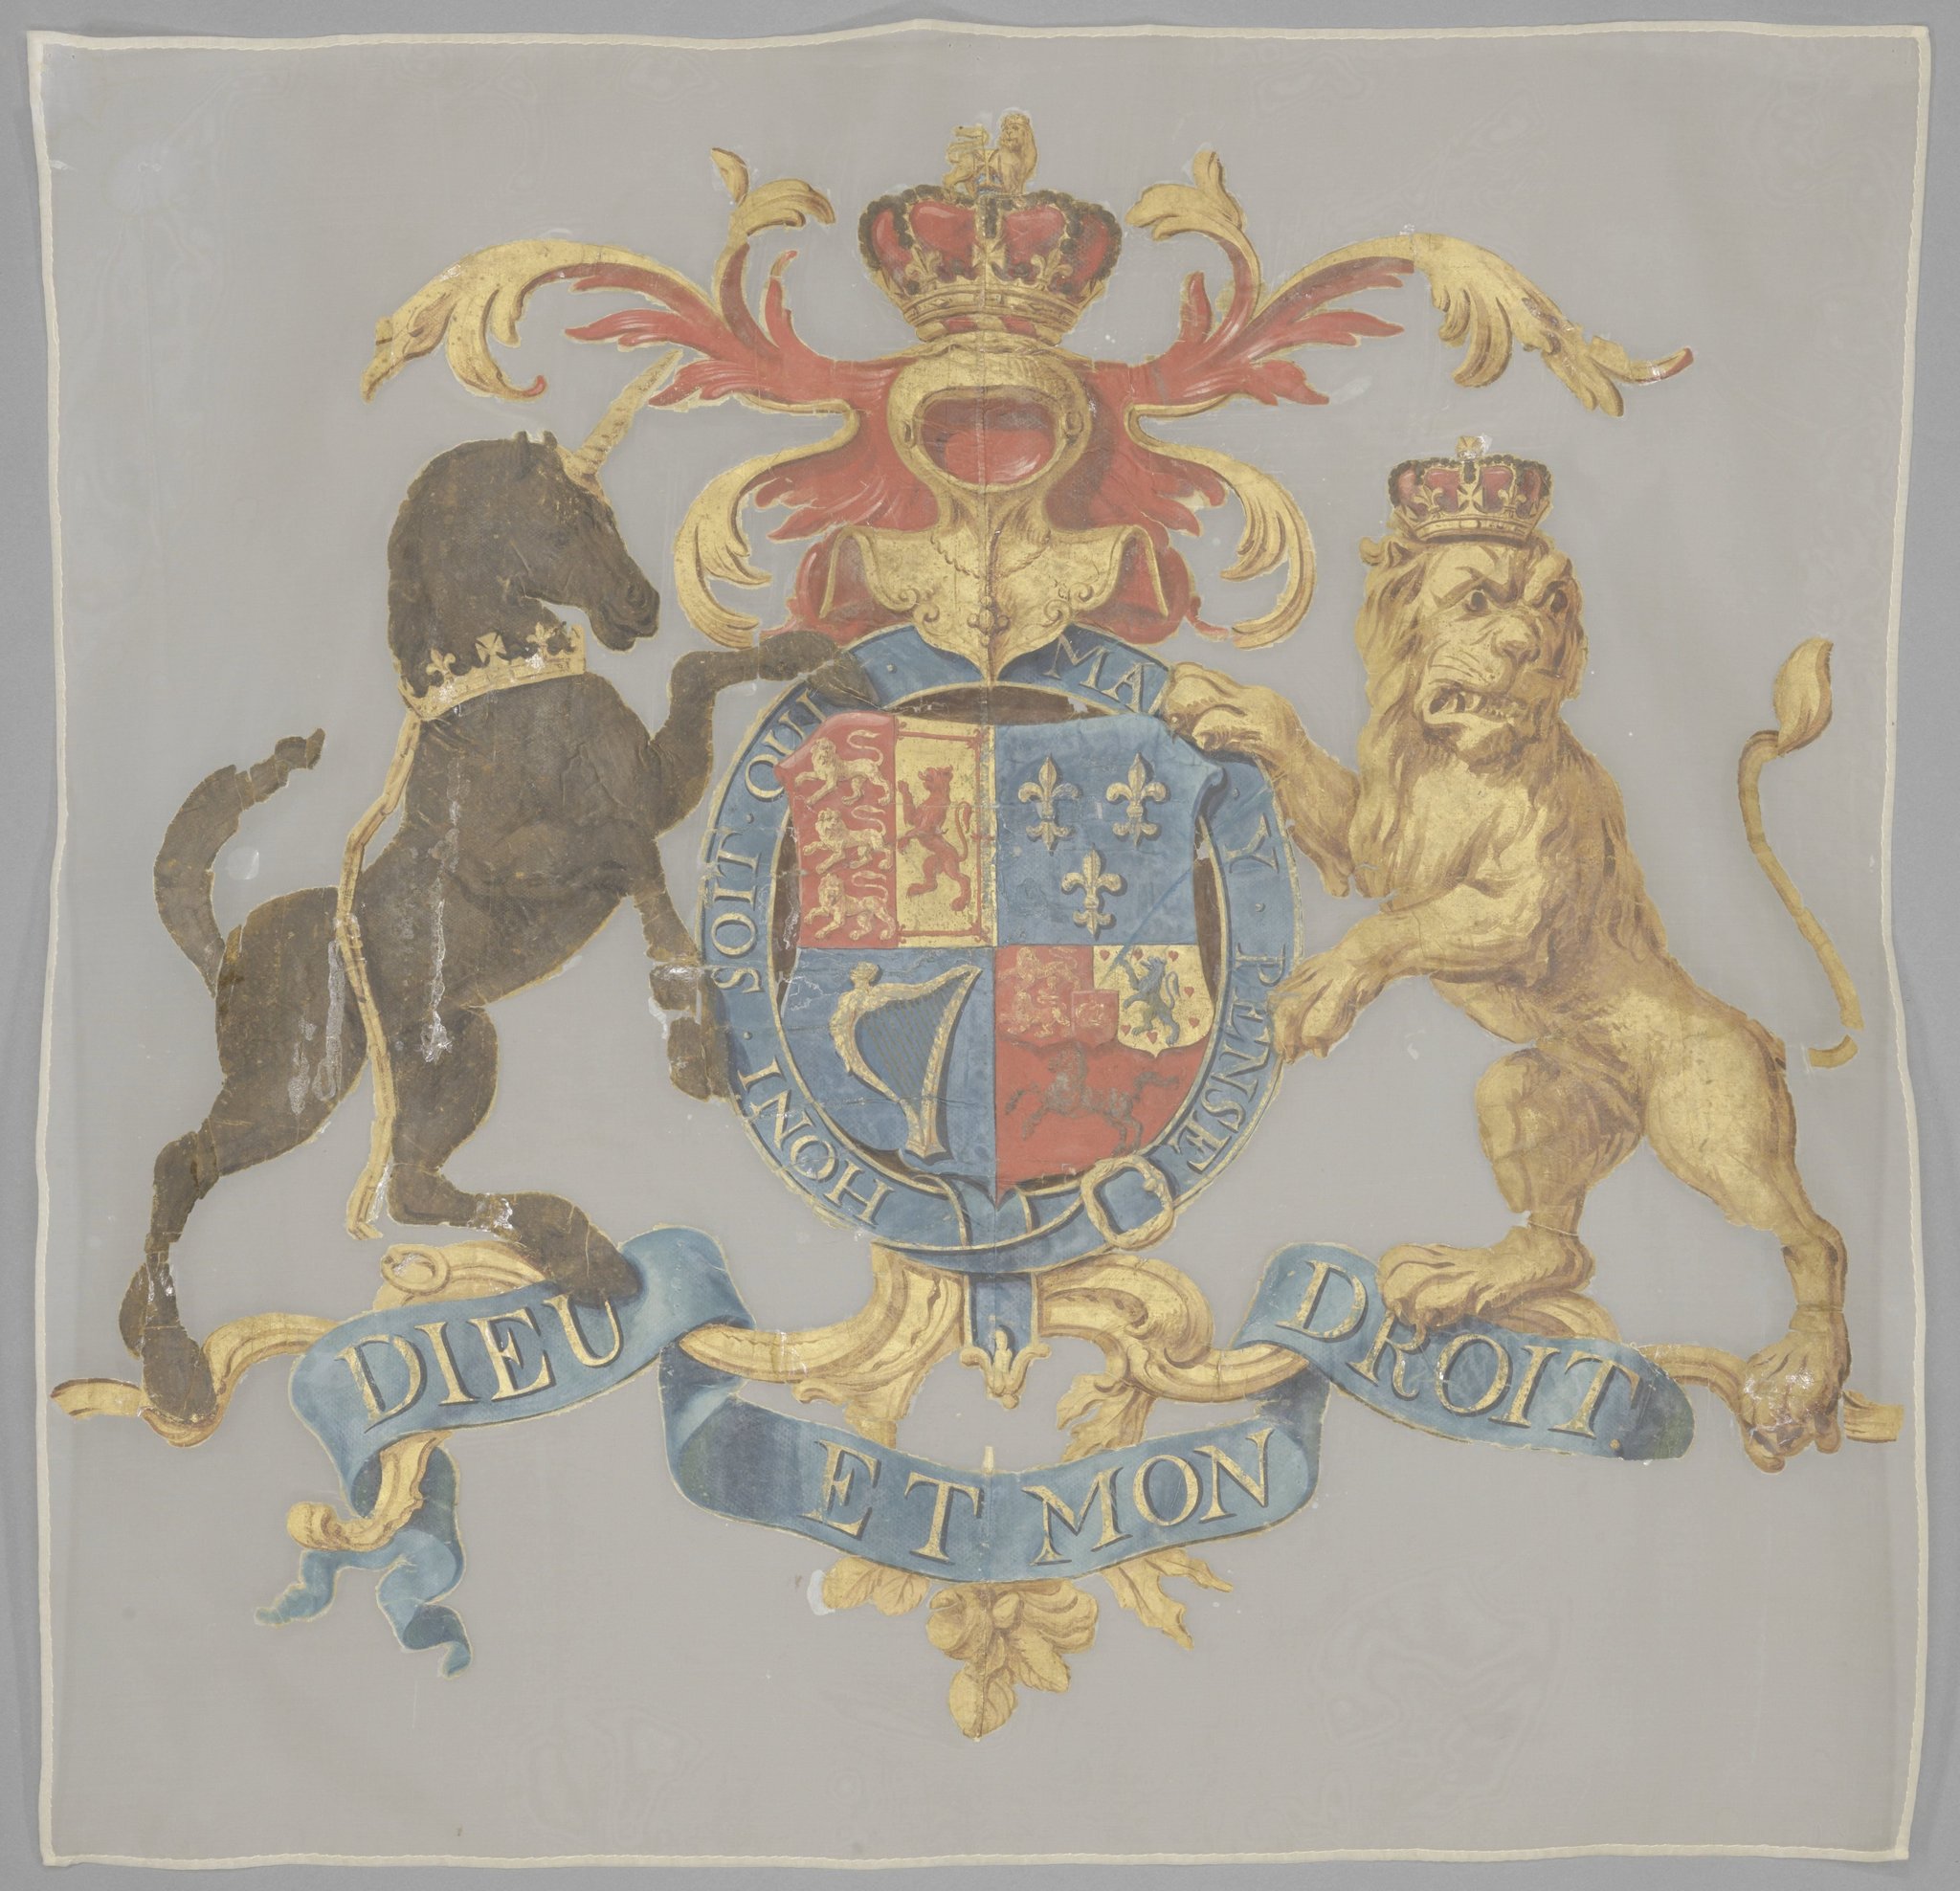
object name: banner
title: Vaandel van een der Schotse regimenten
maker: Anonymous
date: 1750-1783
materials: silk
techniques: lining, painted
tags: england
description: Ecru, op het midden het wapen van de koning van Engeland- Hannover, omgeven door de Orde van de Kousenband (de gesp ervan is aan de voorkant en de paradekant aan vluchtzijde) gehouden door een gekroond aanziend luipaard, en een eenhoorn met een gouden kroon om de hals, waarvan een gouden keten afhangt (resp. symbool van Engeland en dat van Schotland). Erboven een helm met geopend vizier, gedekt met een koningskroon. De helm is omgeven door symmetrisch decoratief lofwerk, dat zich boven de dragers uitstrekt. Onder het wapen is een asymmetrische cartouche. Onder de cartouche een blauwe banderol waarop: DIEU ET MON DROIT. Paradekant identiek, doch de dragers spiegelbeeldig.